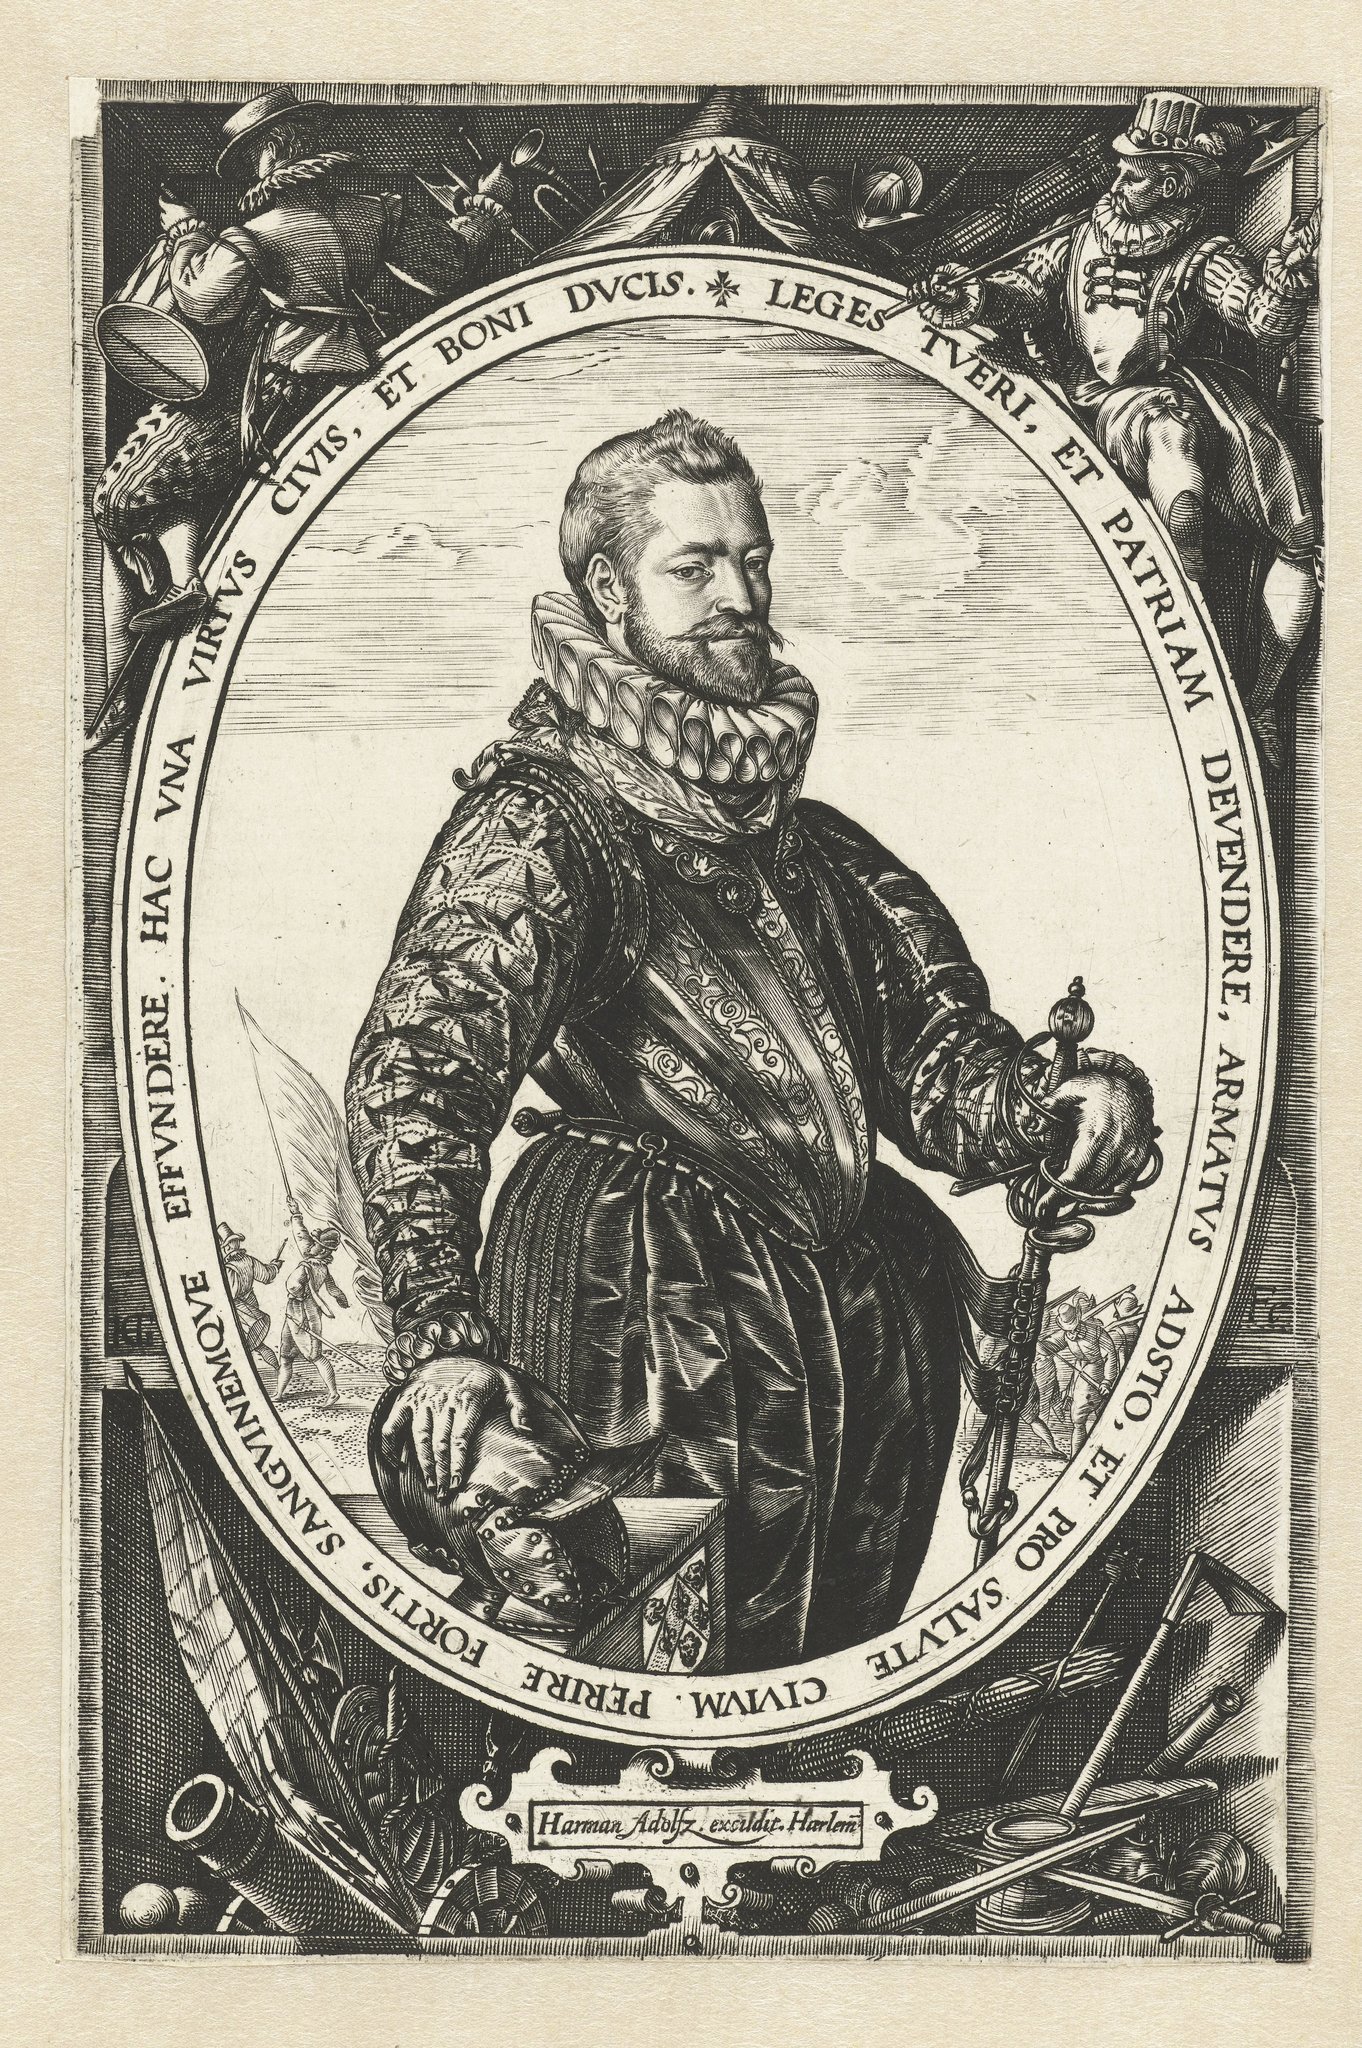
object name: print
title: Portret van Jacques de la Faille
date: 1580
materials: paper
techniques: engraving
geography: haarlem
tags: historical persons, warfare; military affairs (+ citizen soldiery, civil guard, citizen militia), merchant, salesman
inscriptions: address: ‘Harman Adolfsz. excudit Harlem’, signature: ‘HG FE.’, caption: ‘Leges tueri...et boni ducis.’, collector's mark: Lugt 240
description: Portret van Jacques de la Faille (1548-1615), kolonel Antwerpse burgerwacht, na 1584 koopman in Haarlem. Staand, gedraaid naar links, rechterhand leunend op helm, linkerhand op zwaard. Voornaam gekleed. In ovaal met randschrift. Pendant van portret van echtgenote Josina Hamels.